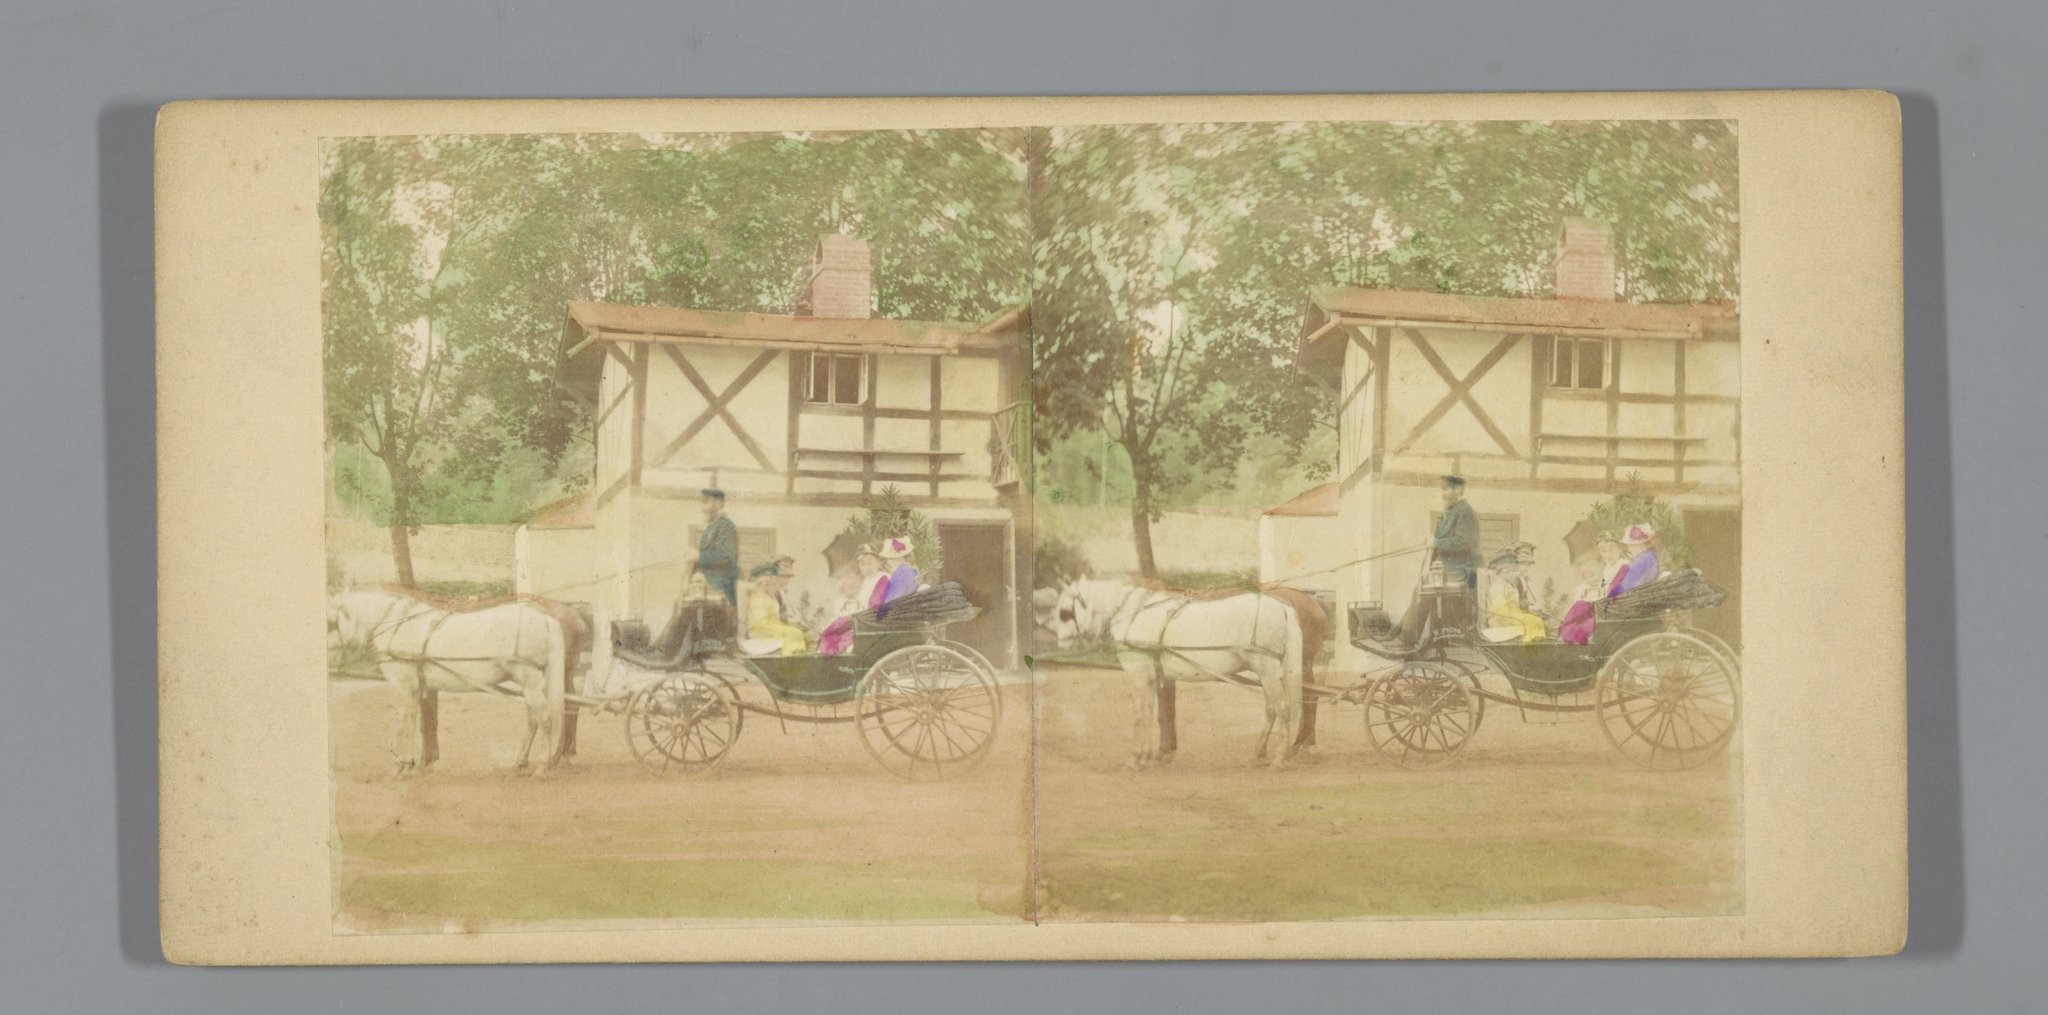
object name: stereograph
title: Gezelschap in een open koets met paarden voor een huis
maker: Anonymous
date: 1852-1863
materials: cardboard, paper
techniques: albumen print, hand coloring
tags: rural housing, e.g. country-house, villa, cottage, four-wheeled vehicle drawn by two animals